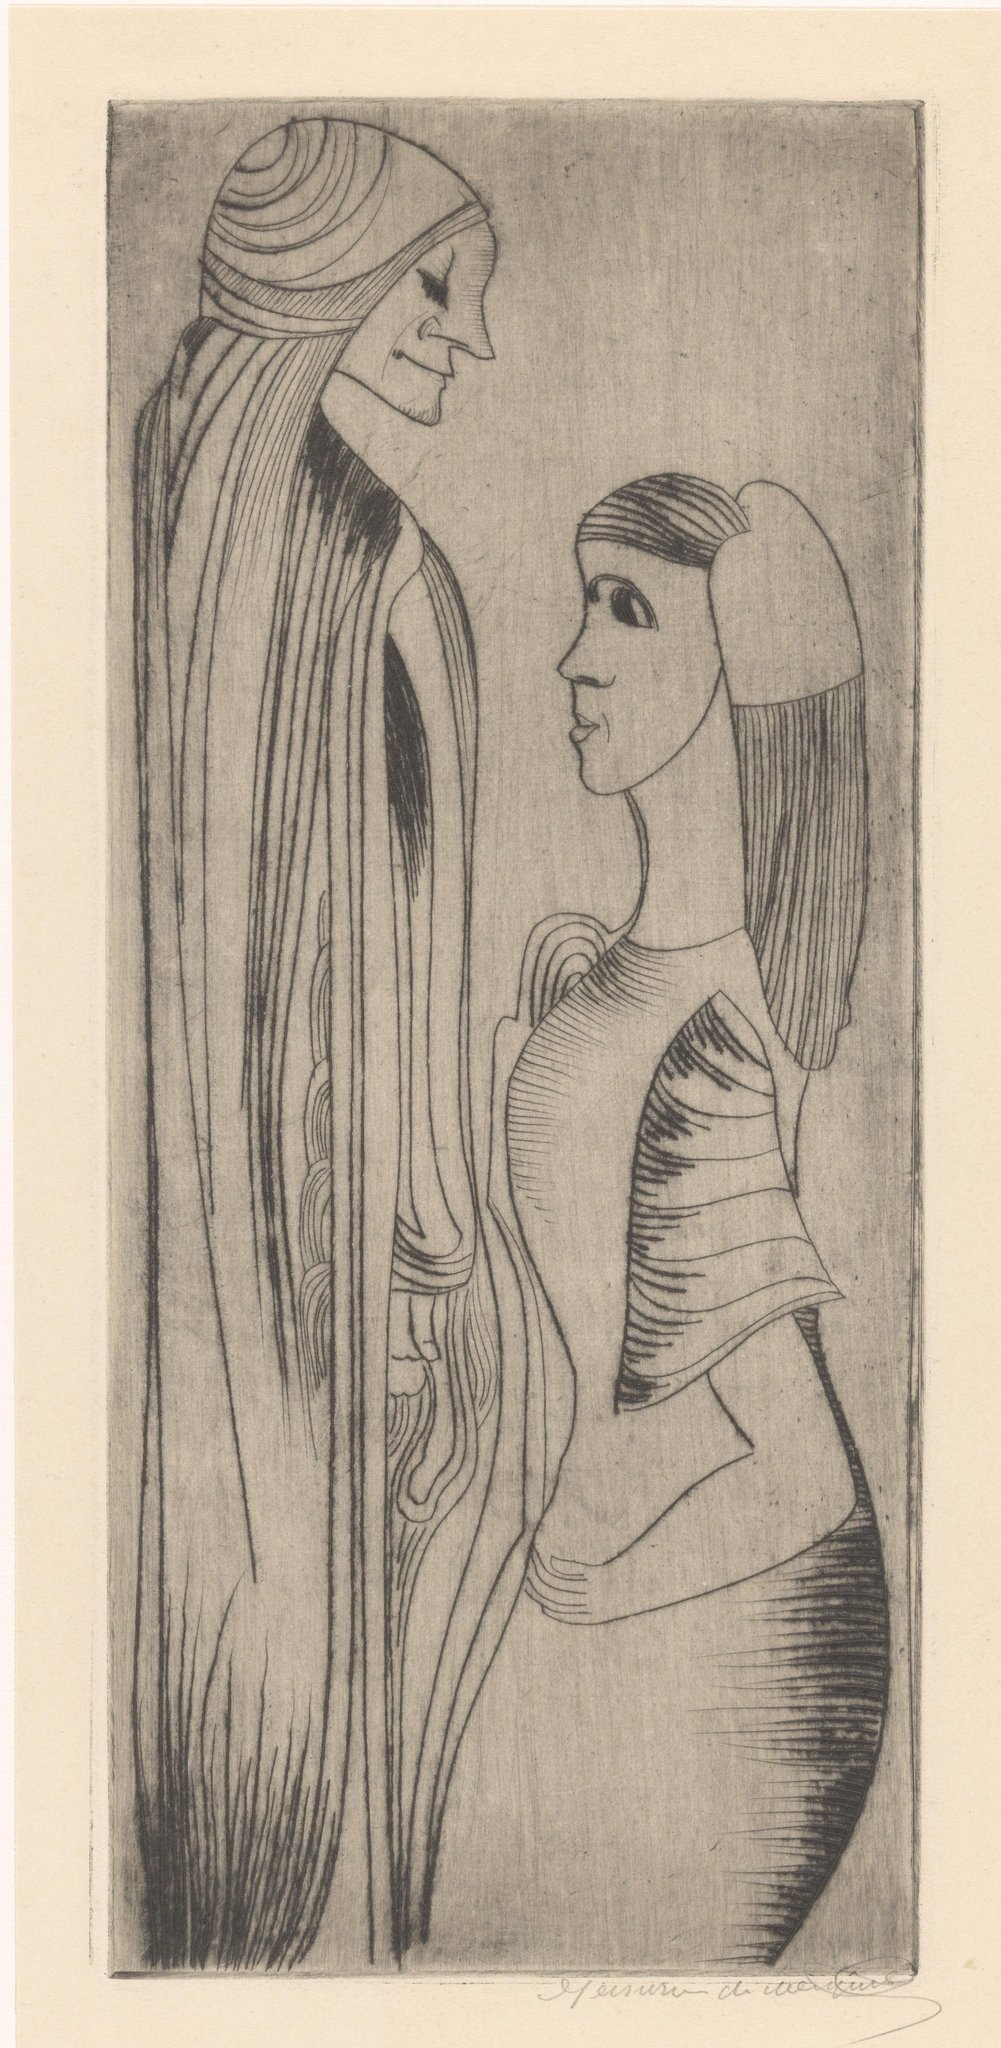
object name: print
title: Fantasie: twee figuren in profiel, naar elkaar gewend (links met geloken ogen en kap, rechts een vrouw)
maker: samuel jessurun de mesquita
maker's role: draughtsman, print maker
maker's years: 1868-1944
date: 1924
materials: paper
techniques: etching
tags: eyes closed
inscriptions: collector's mark: Lugt 2228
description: Links een man met gesloten ogen; rechts een vrouw met een band in het haar.